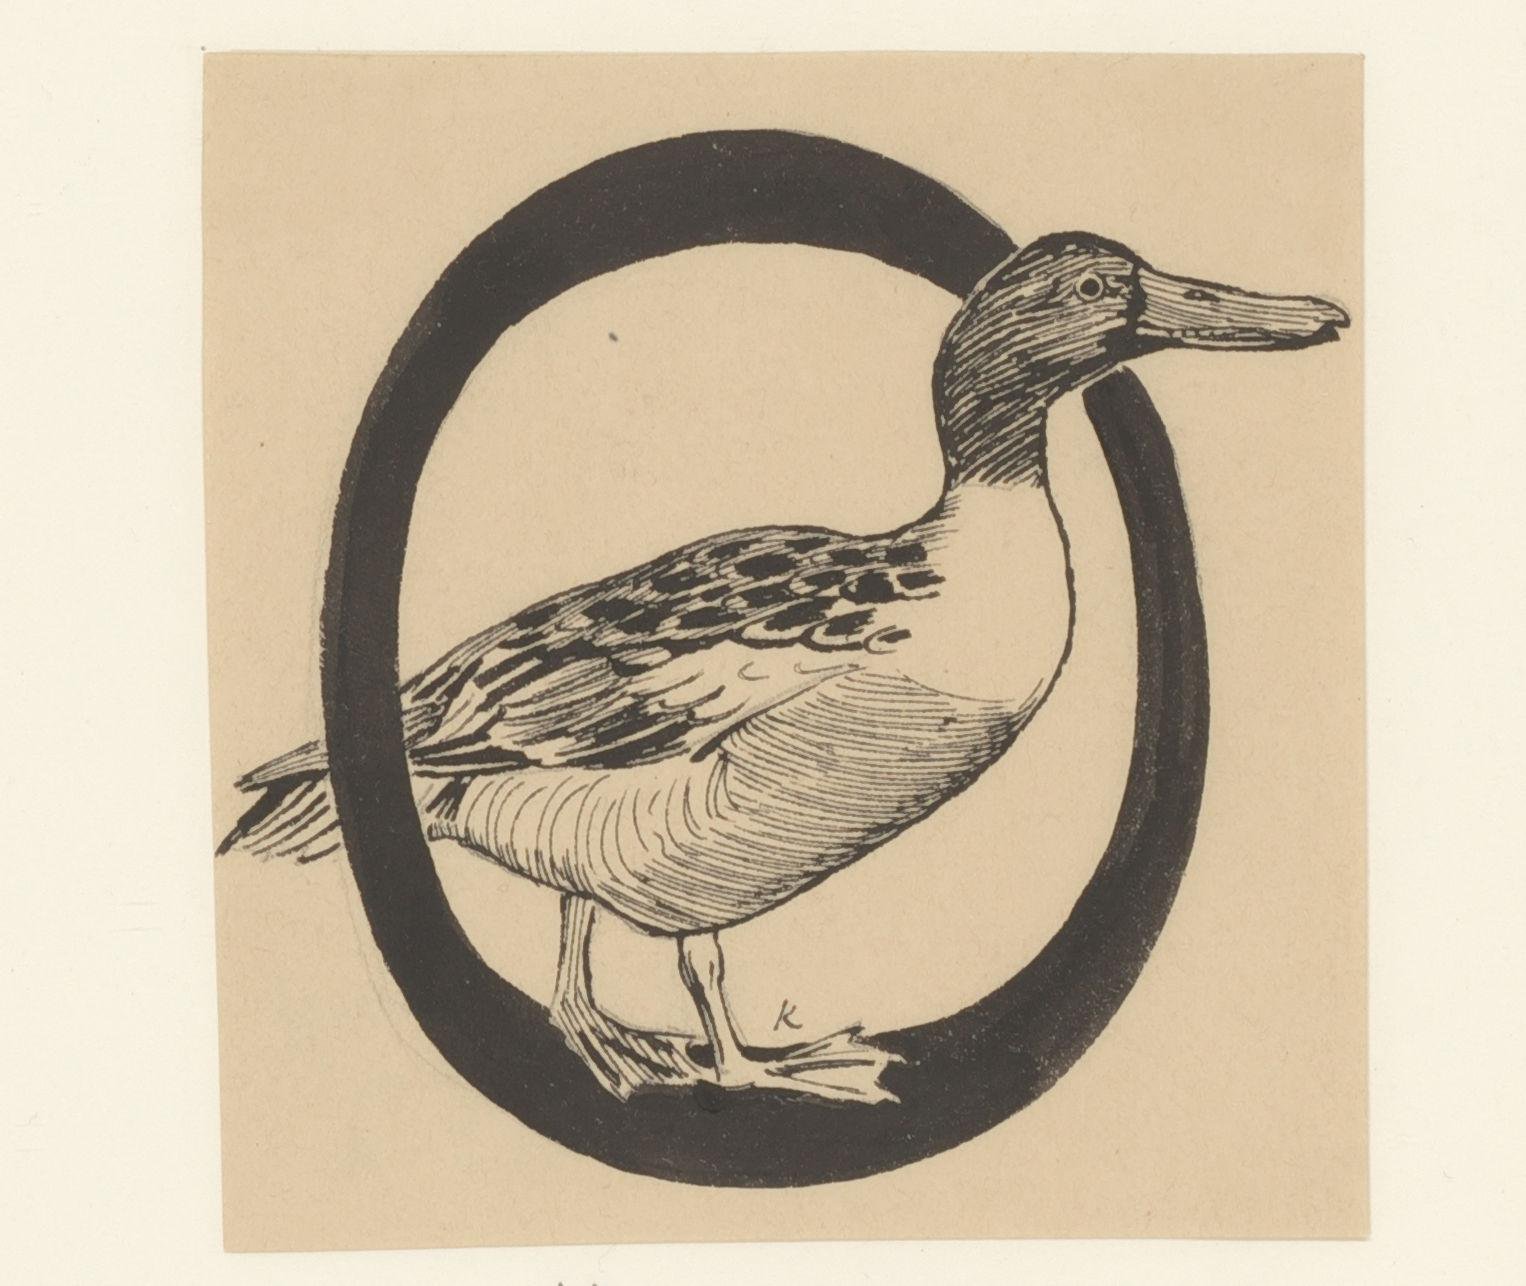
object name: illustratie ontwerp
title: Letter O met eend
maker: heinrich m. krabbé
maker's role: draughtsman, print maker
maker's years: 1868-1931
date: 1899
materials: ink, paper, pencil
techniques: brush, pen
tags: letters, alphabet, script, water-birds: duck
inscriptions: stamp, collector's mark: Lugt 1641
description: Onderwerpsrubrieken binnen de Atlas Zeden en Gewoonten: Handel, Nijverheid en Verkeer, Beroep en bedrijf, Mannelijk, Eet- en drinkwaren.